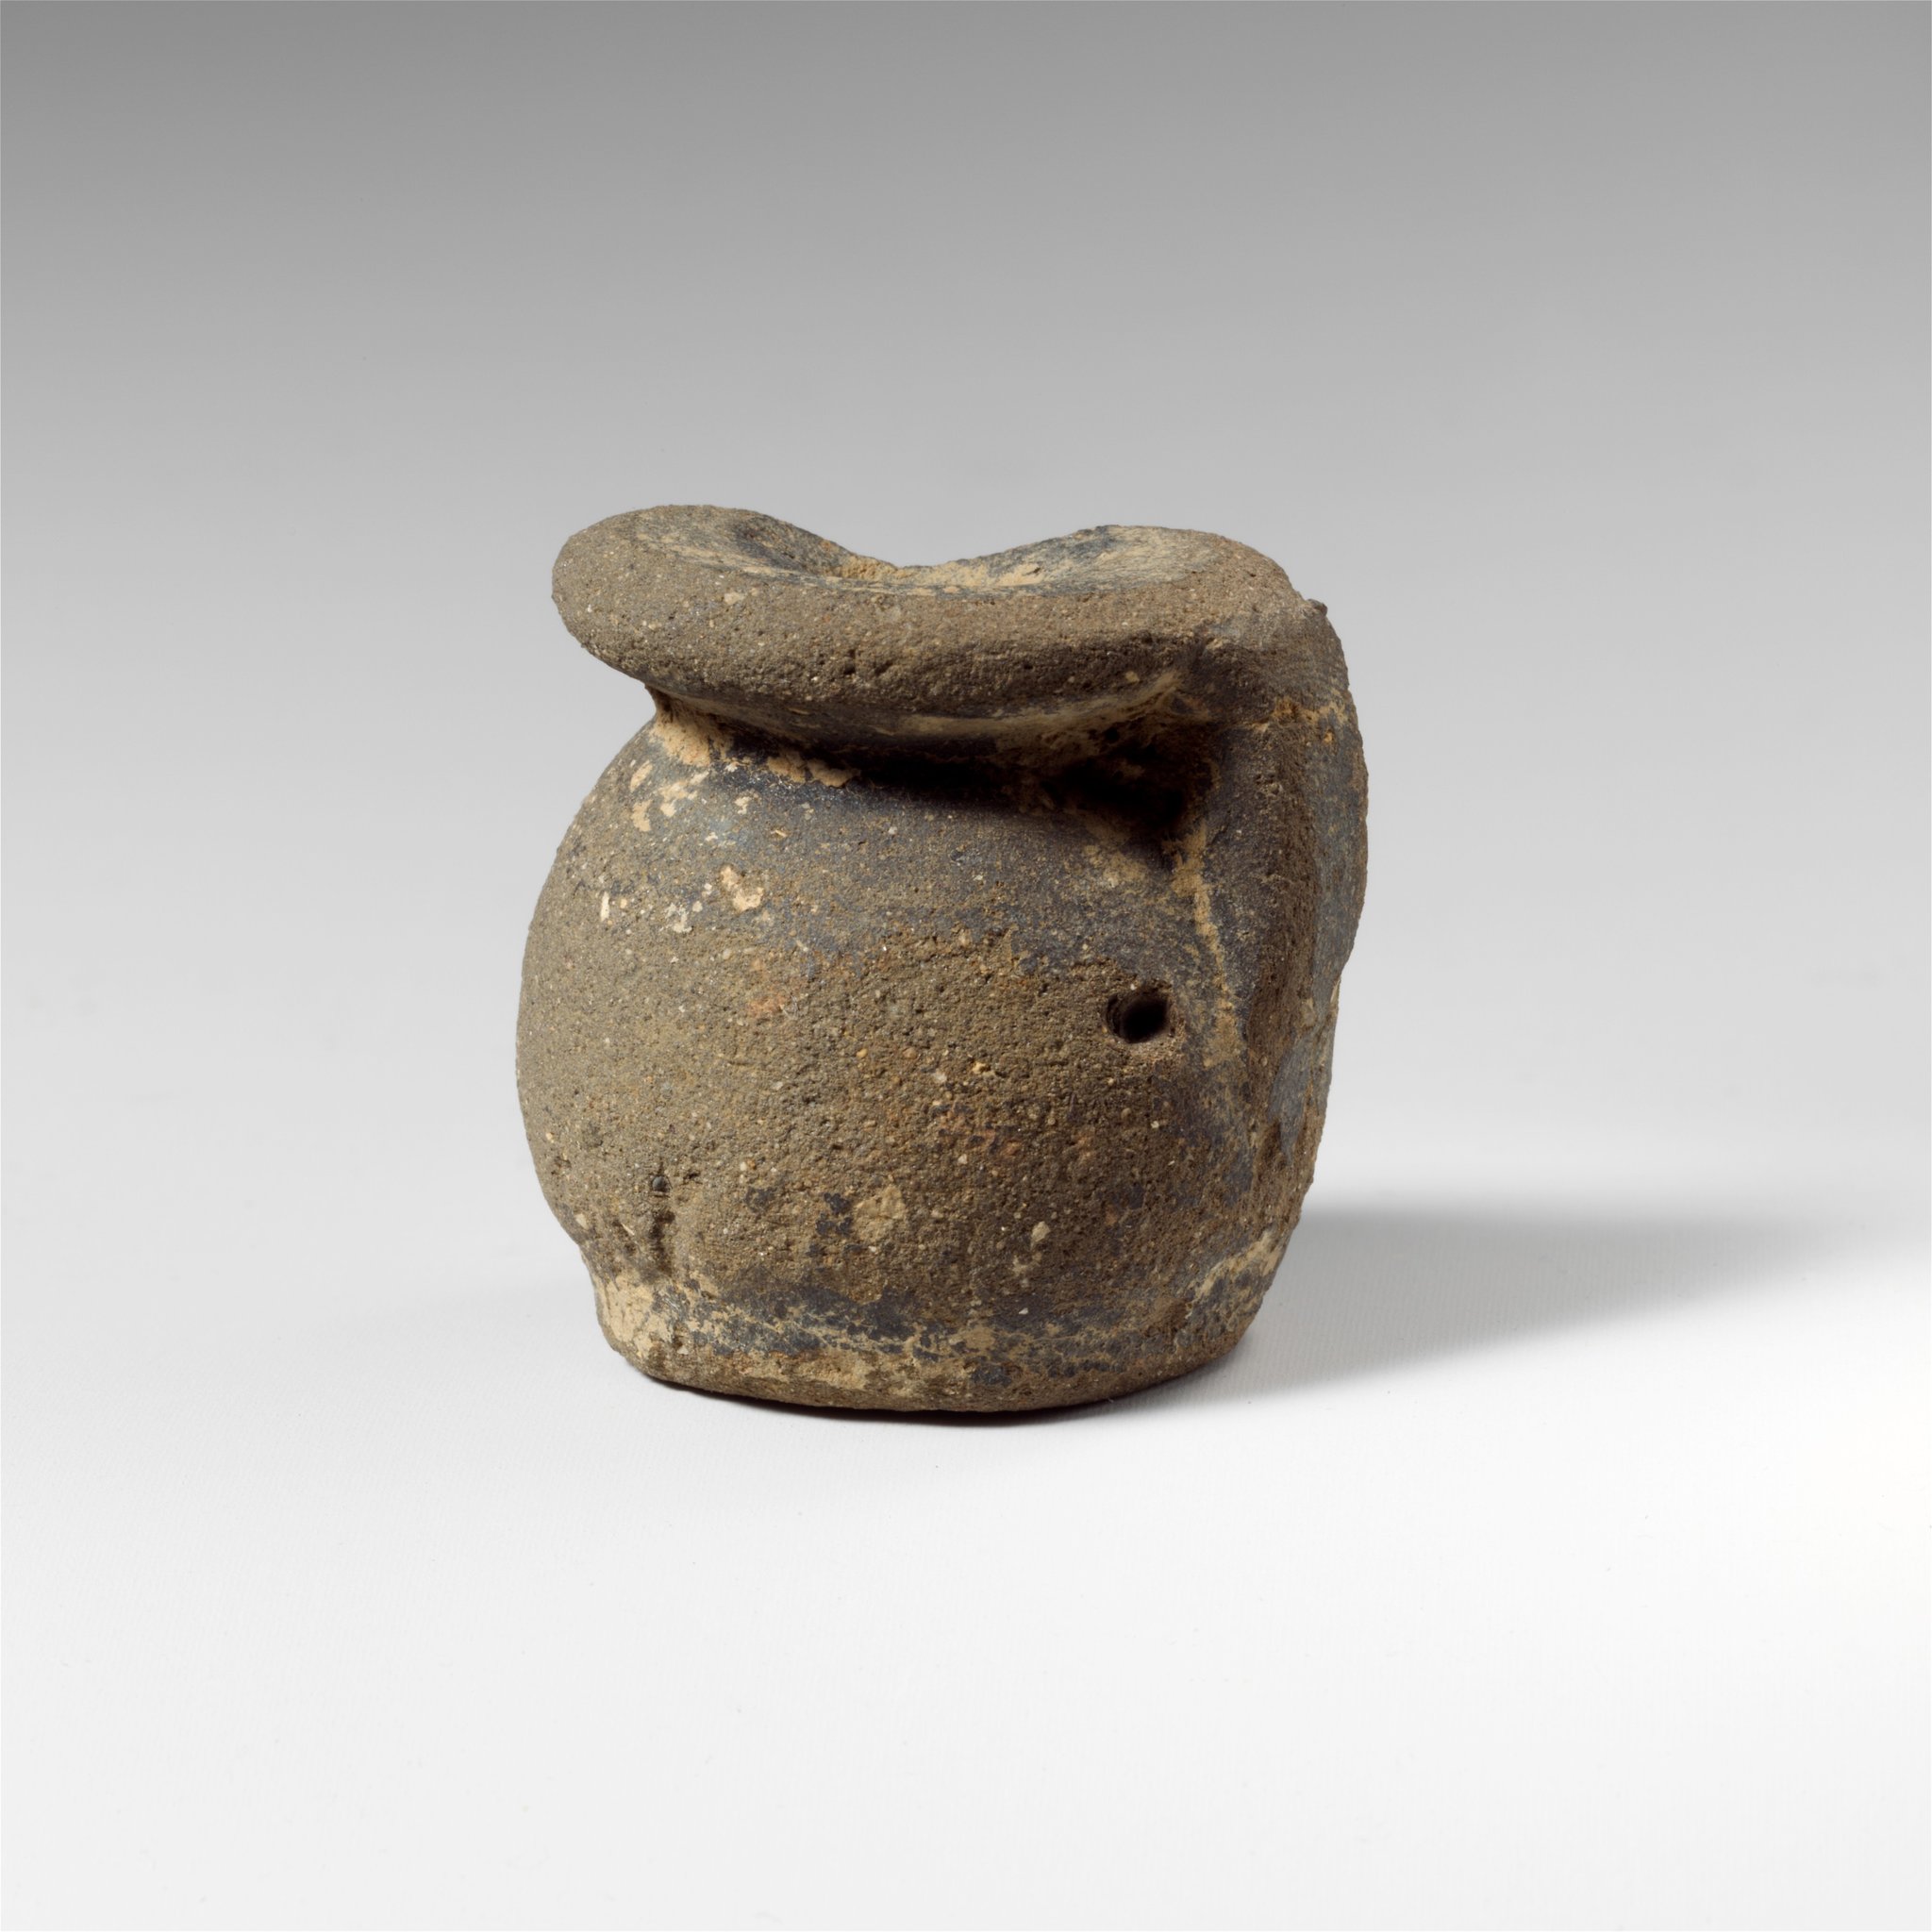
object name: vase, miniature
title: Terracotta miniature vase with one handle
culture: greek, laconian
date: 700-501 BCE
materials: terracotta